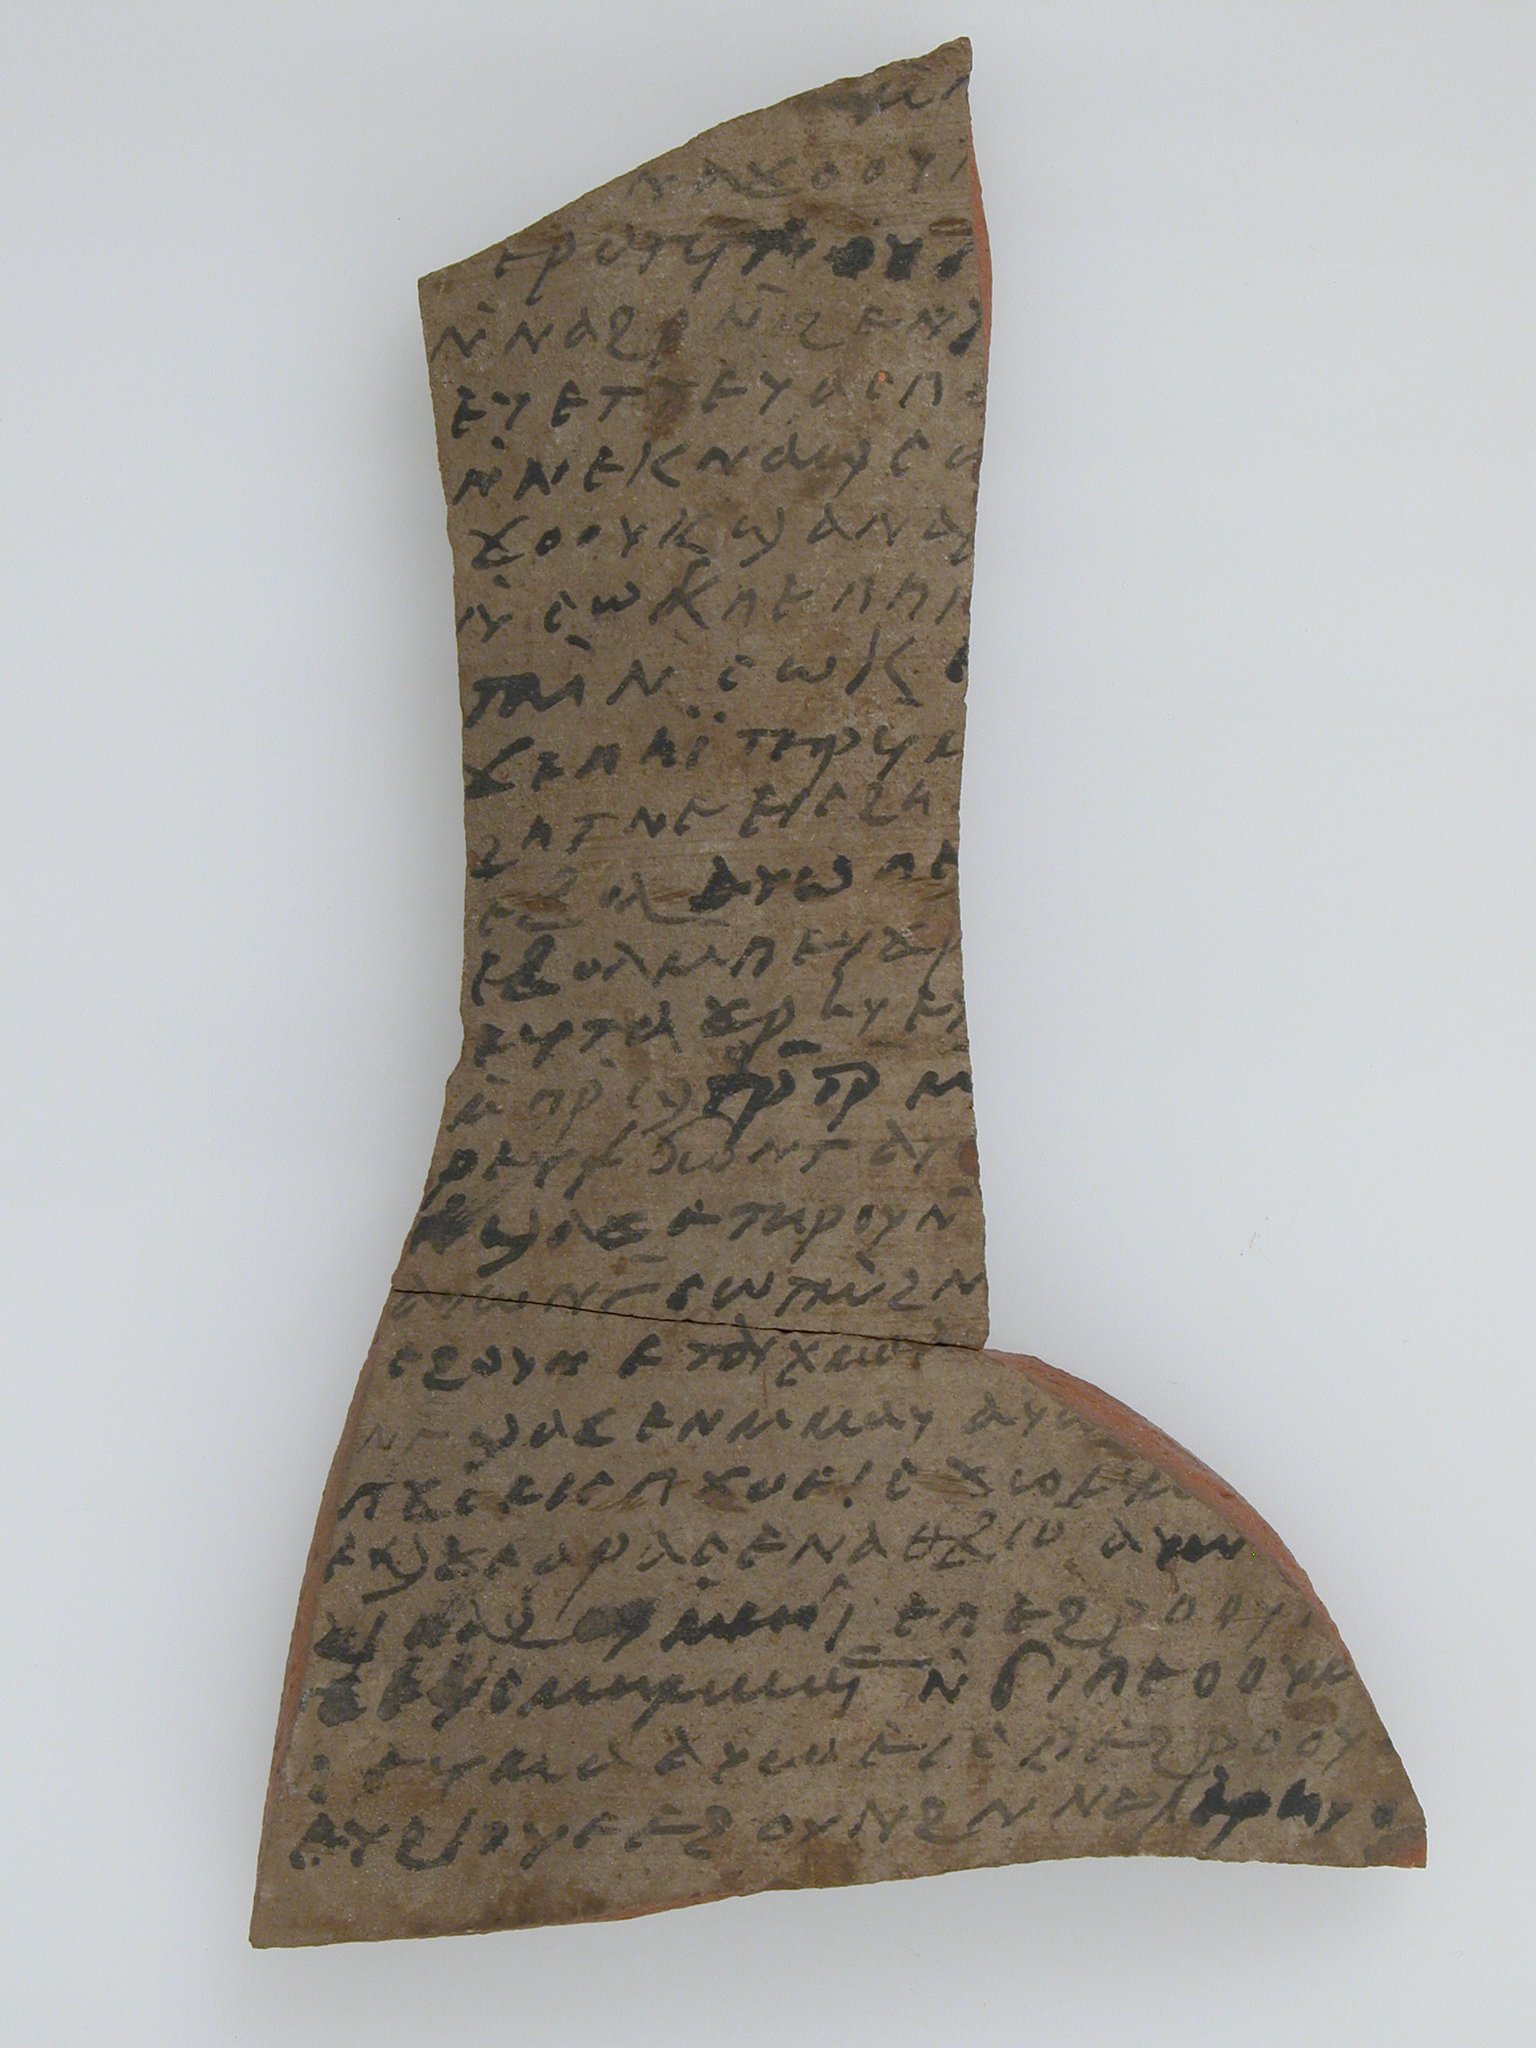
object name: ostrakon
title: Ostrakon with Biblical Text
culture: coptic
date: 600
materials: ink, pottery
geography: egypt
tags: coptic